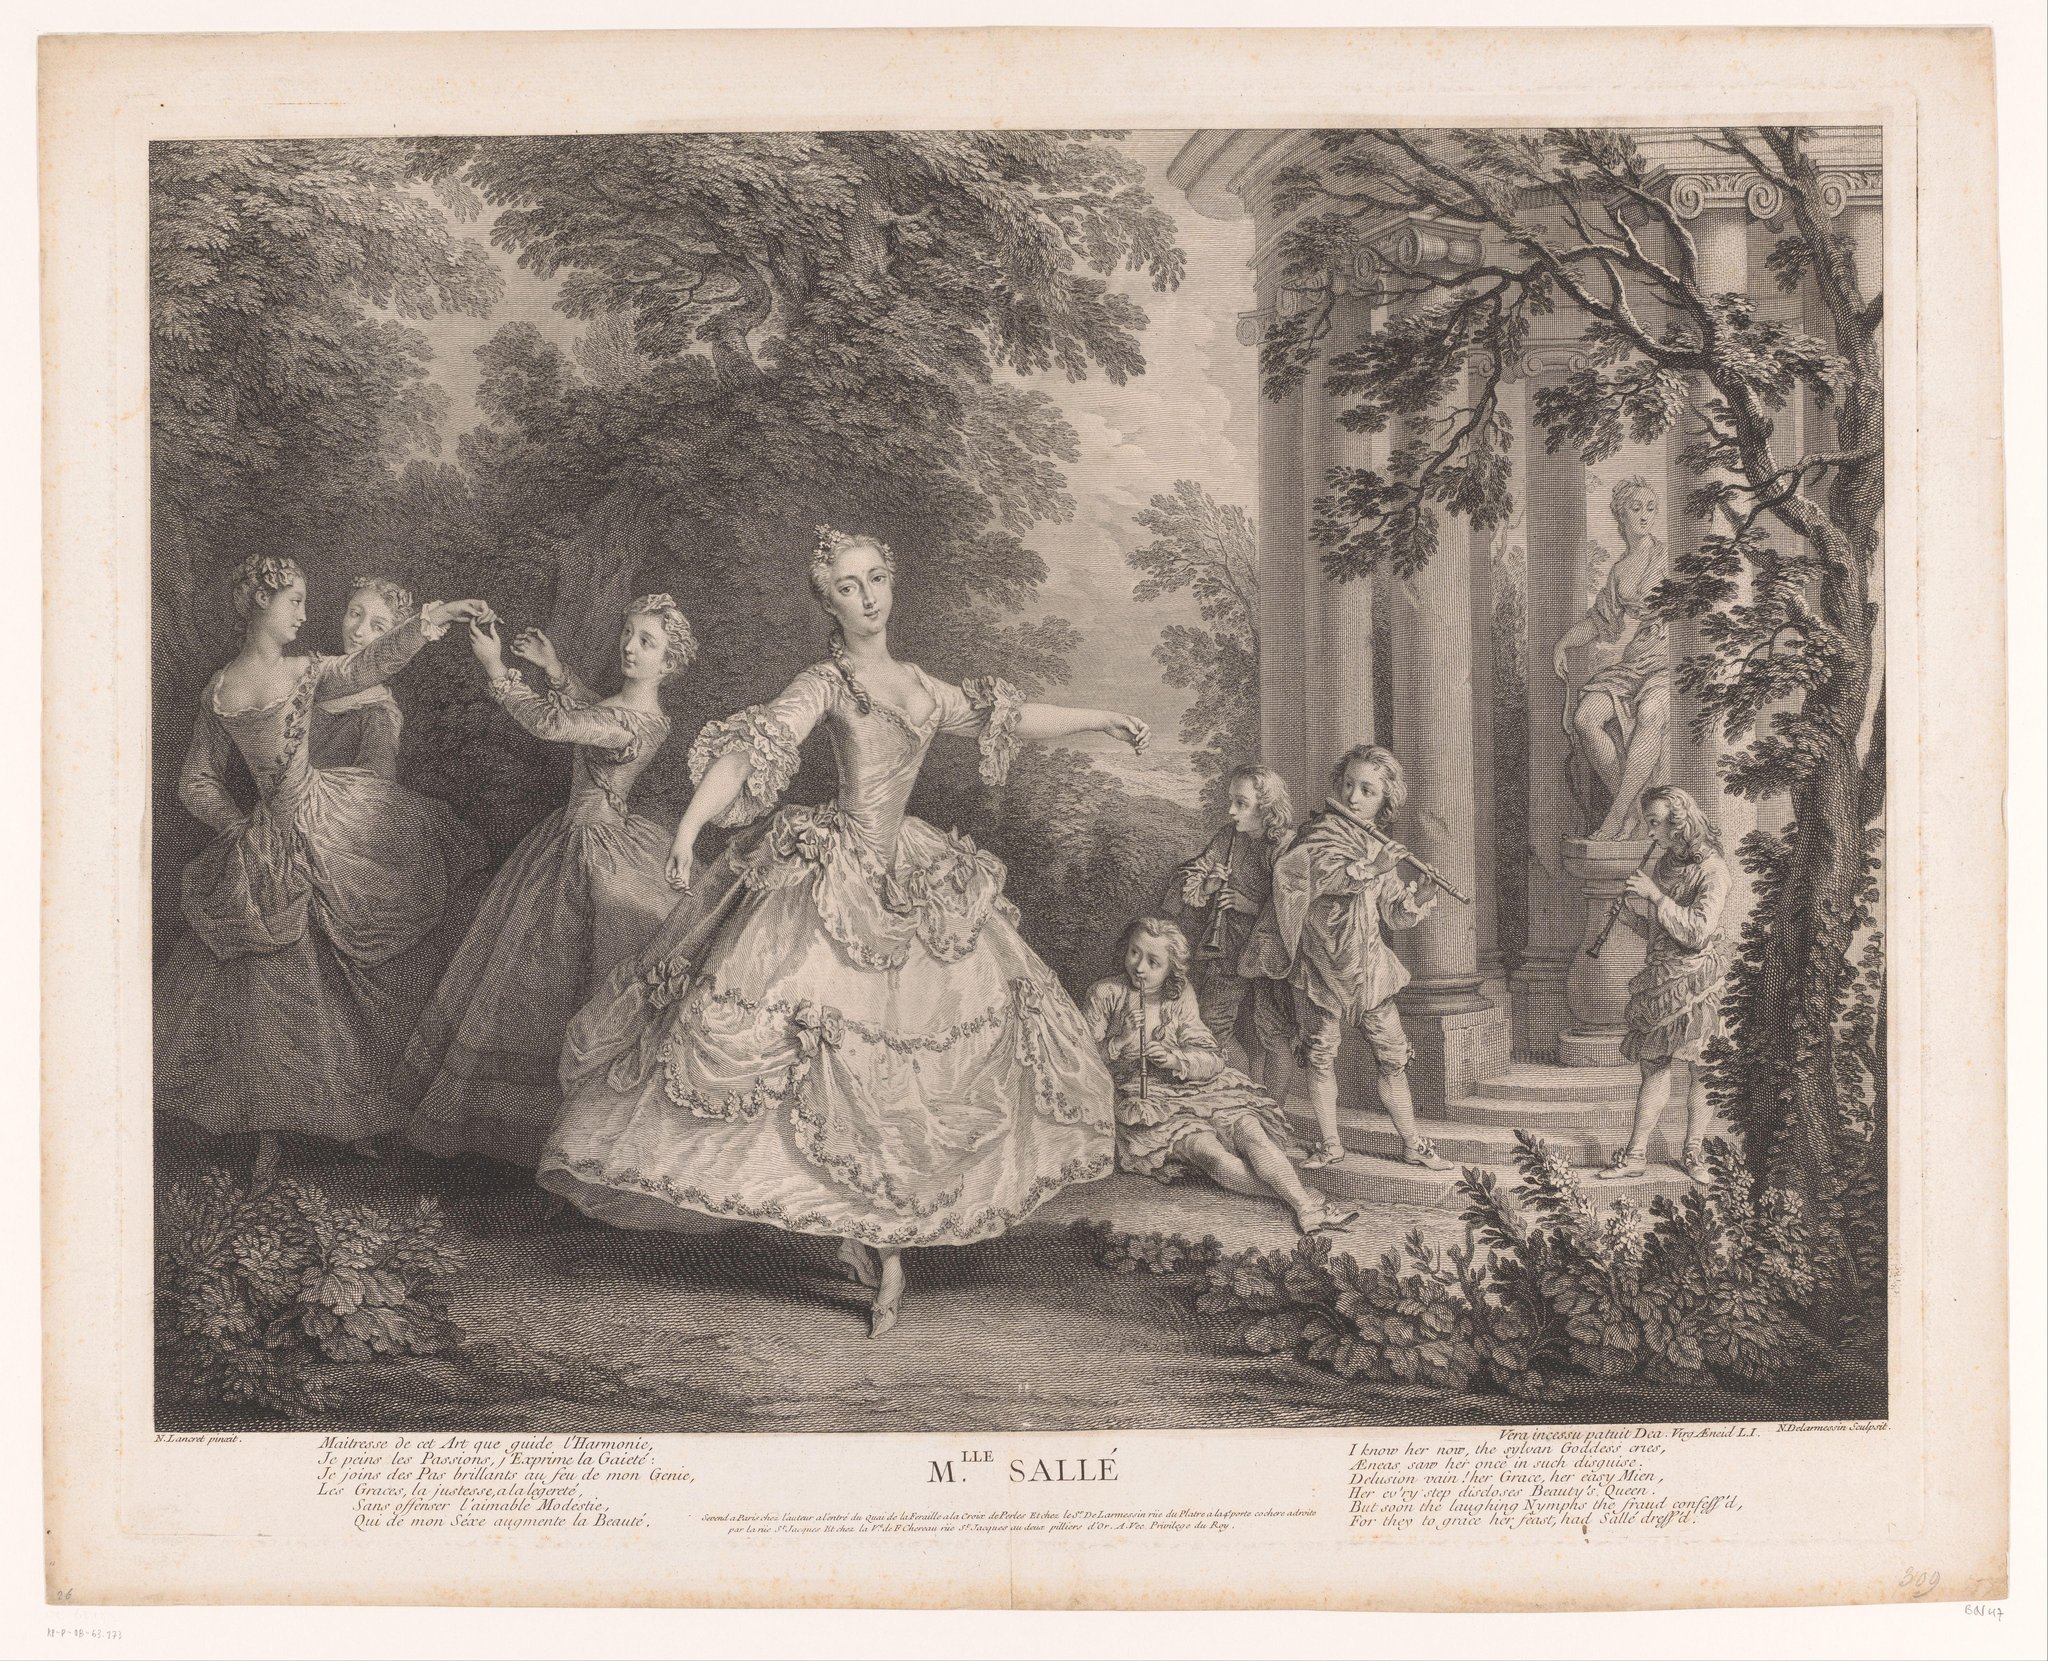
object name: print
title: Mlle. Sallé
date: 1694-1755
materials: paper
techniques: engraving, etching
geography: paris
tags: historical persons - bb - woman, portrait of dancer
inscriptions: collector's mark: Lugt 240